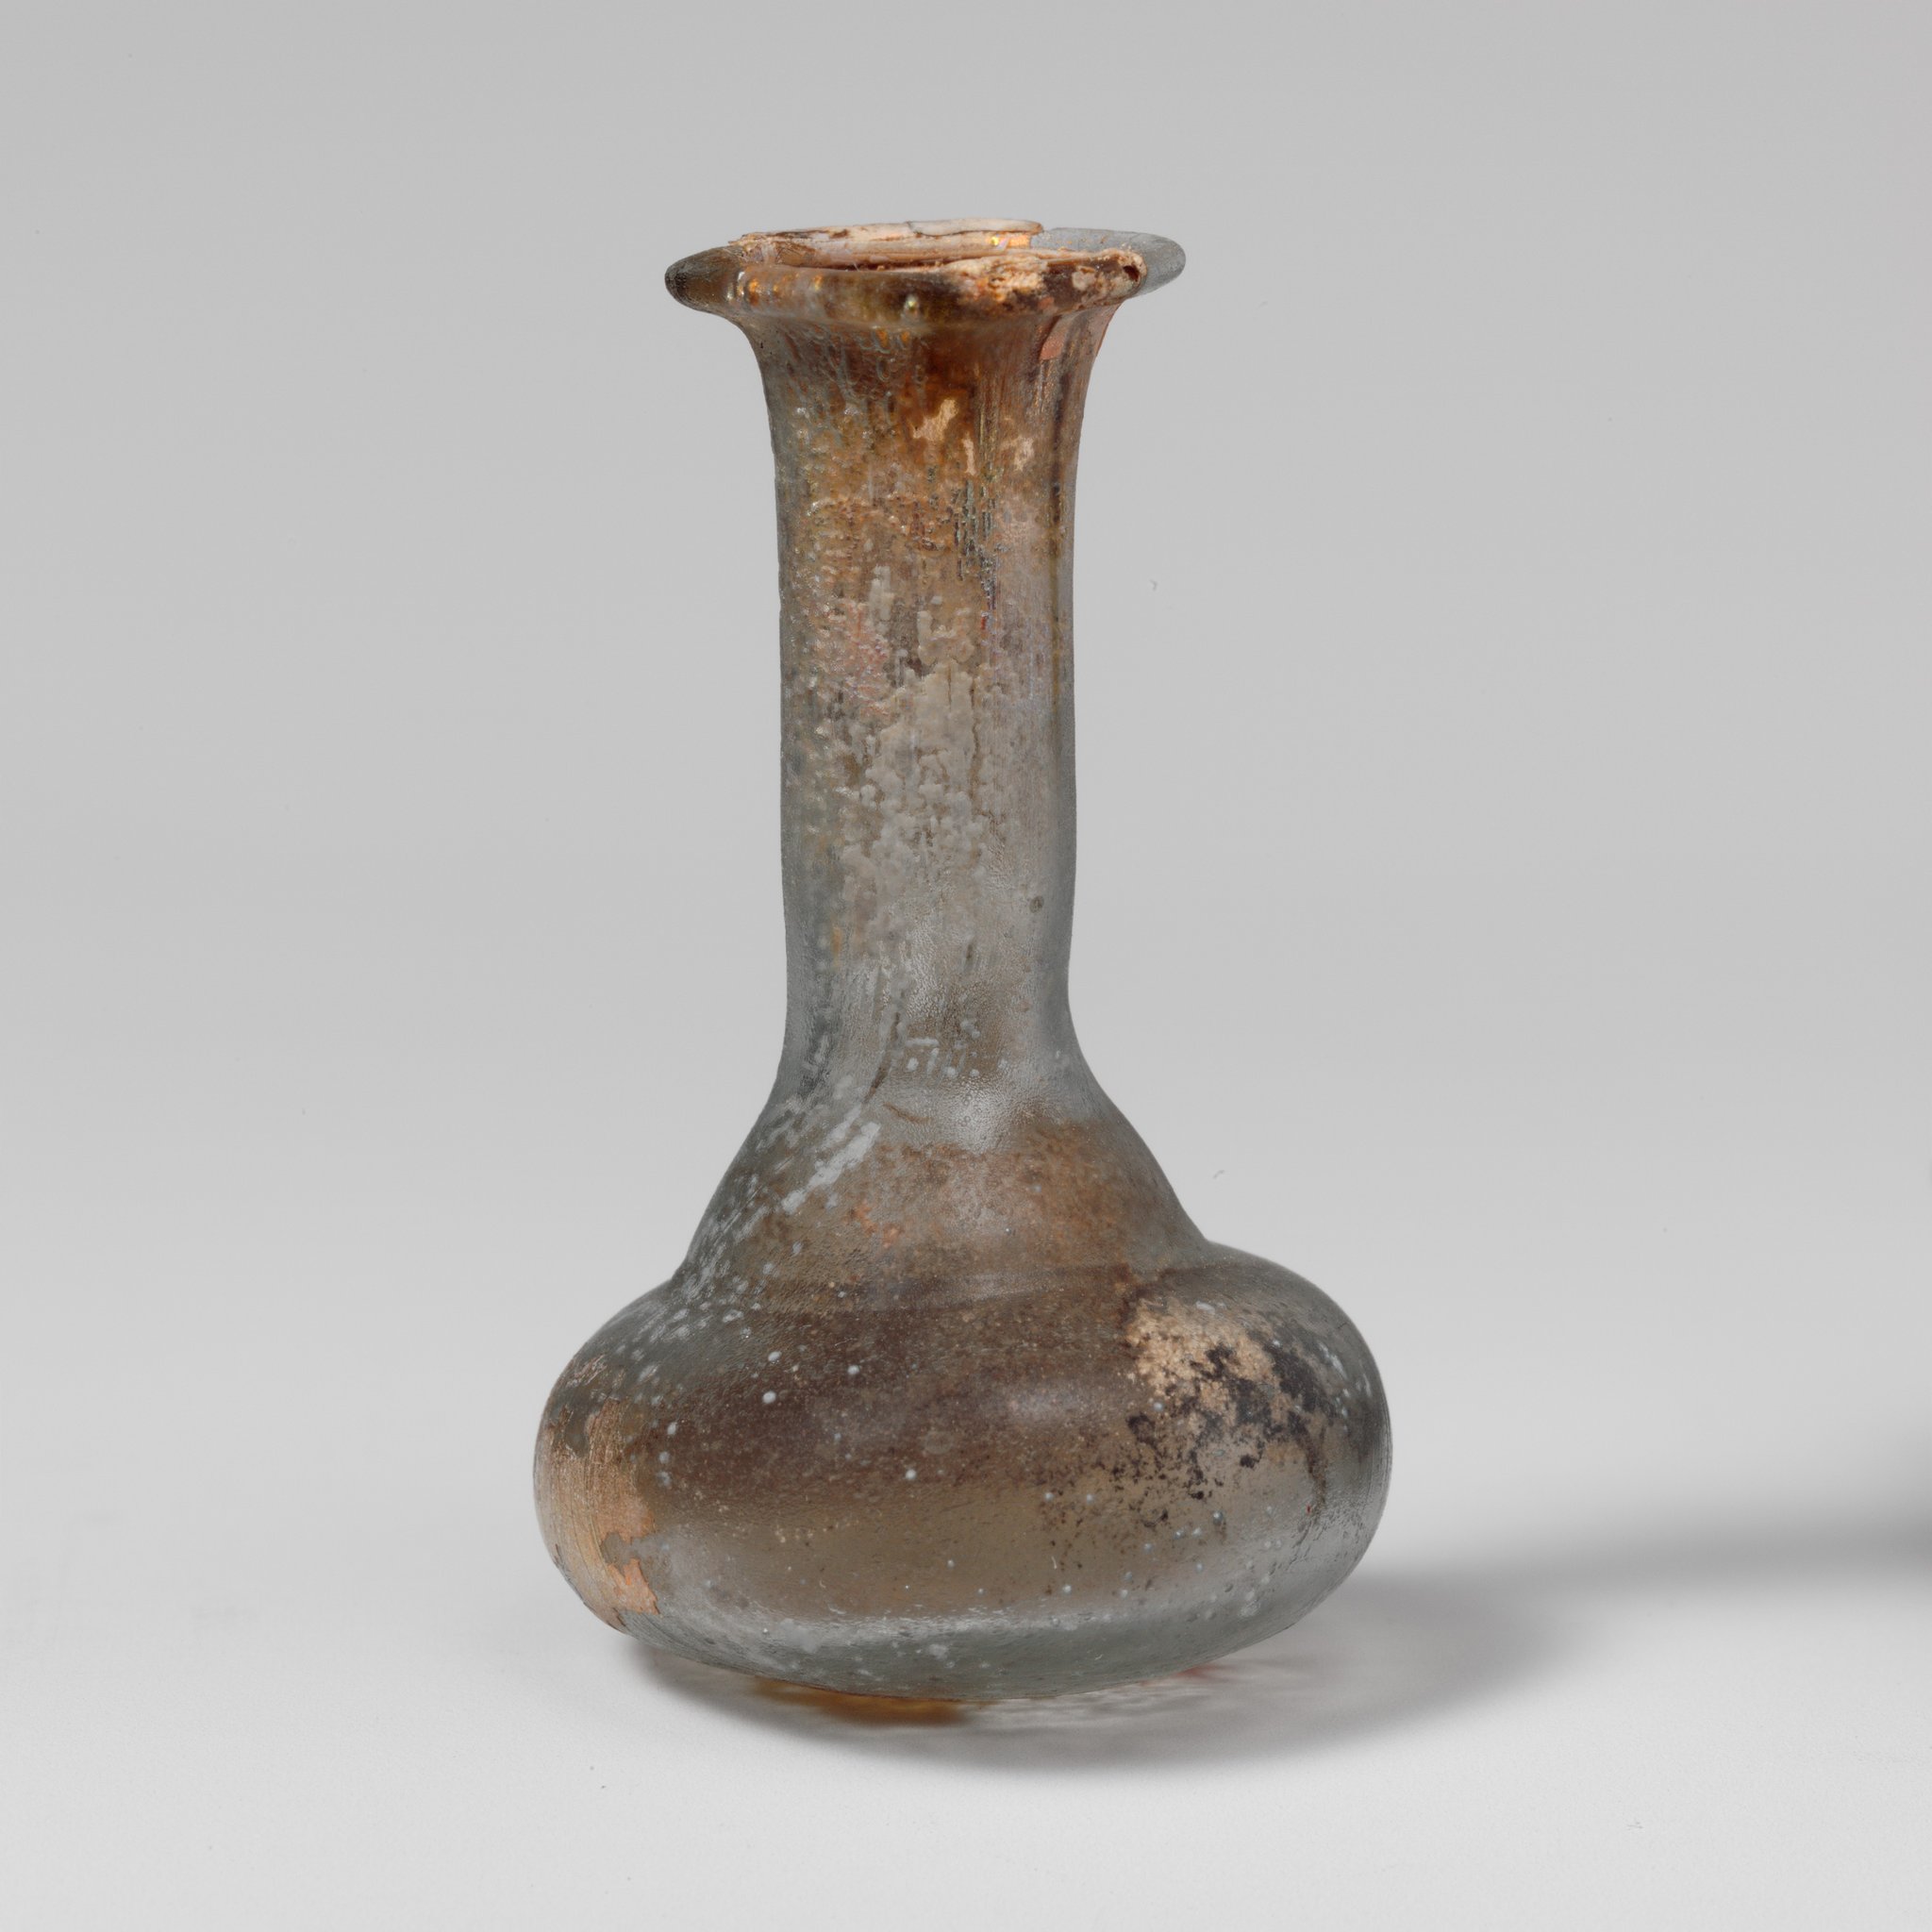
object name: perfume bottle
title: Glass perfume bottle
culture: roman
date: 1-100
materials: glass